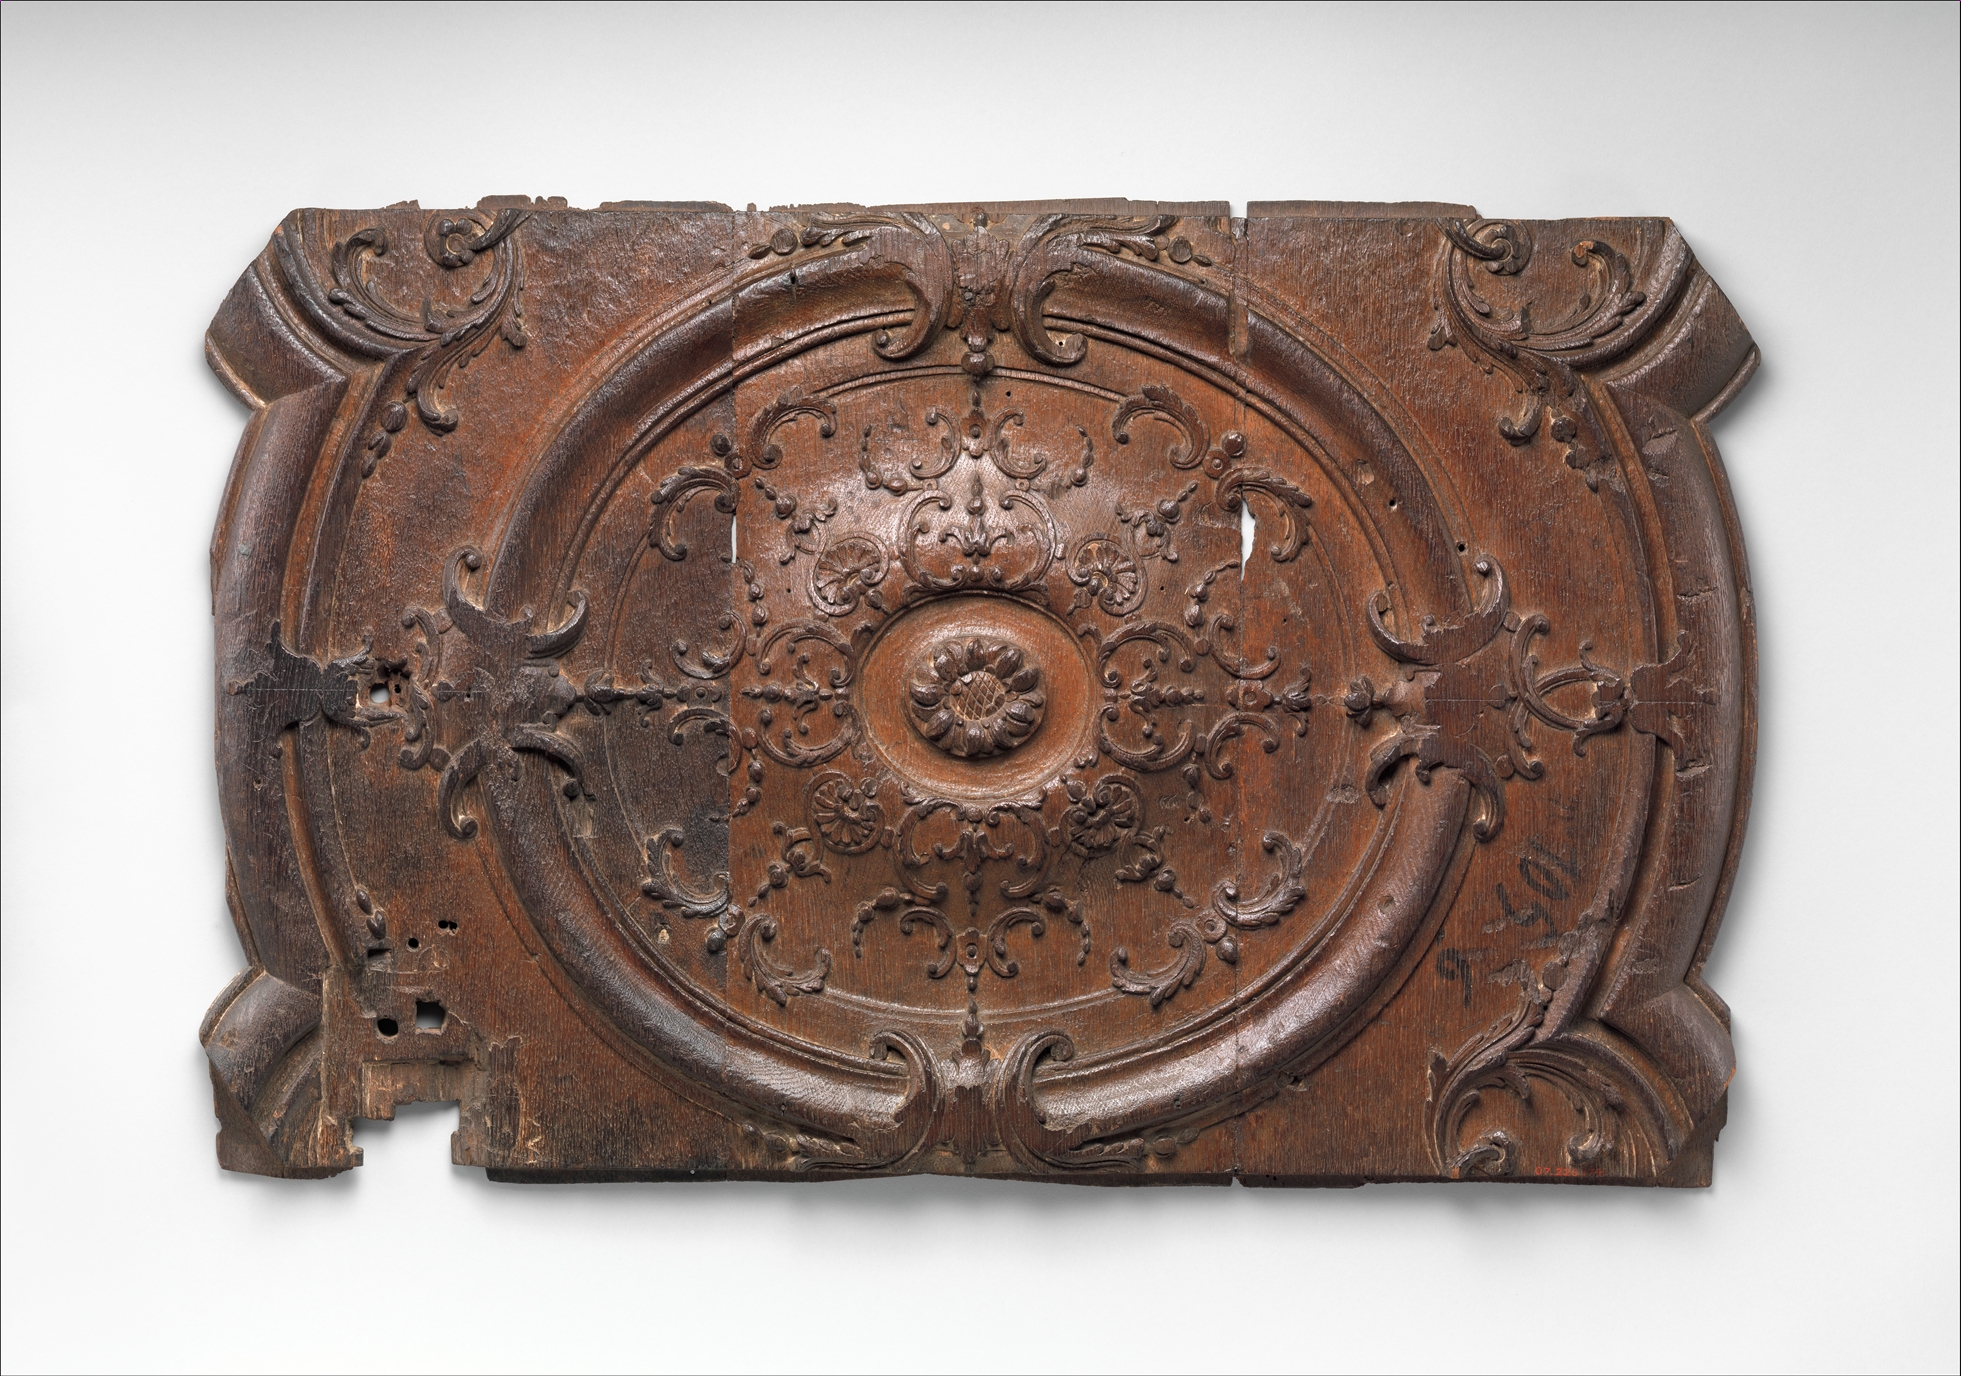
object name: door fragment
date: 1667-1733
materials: wood, wax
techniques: polish